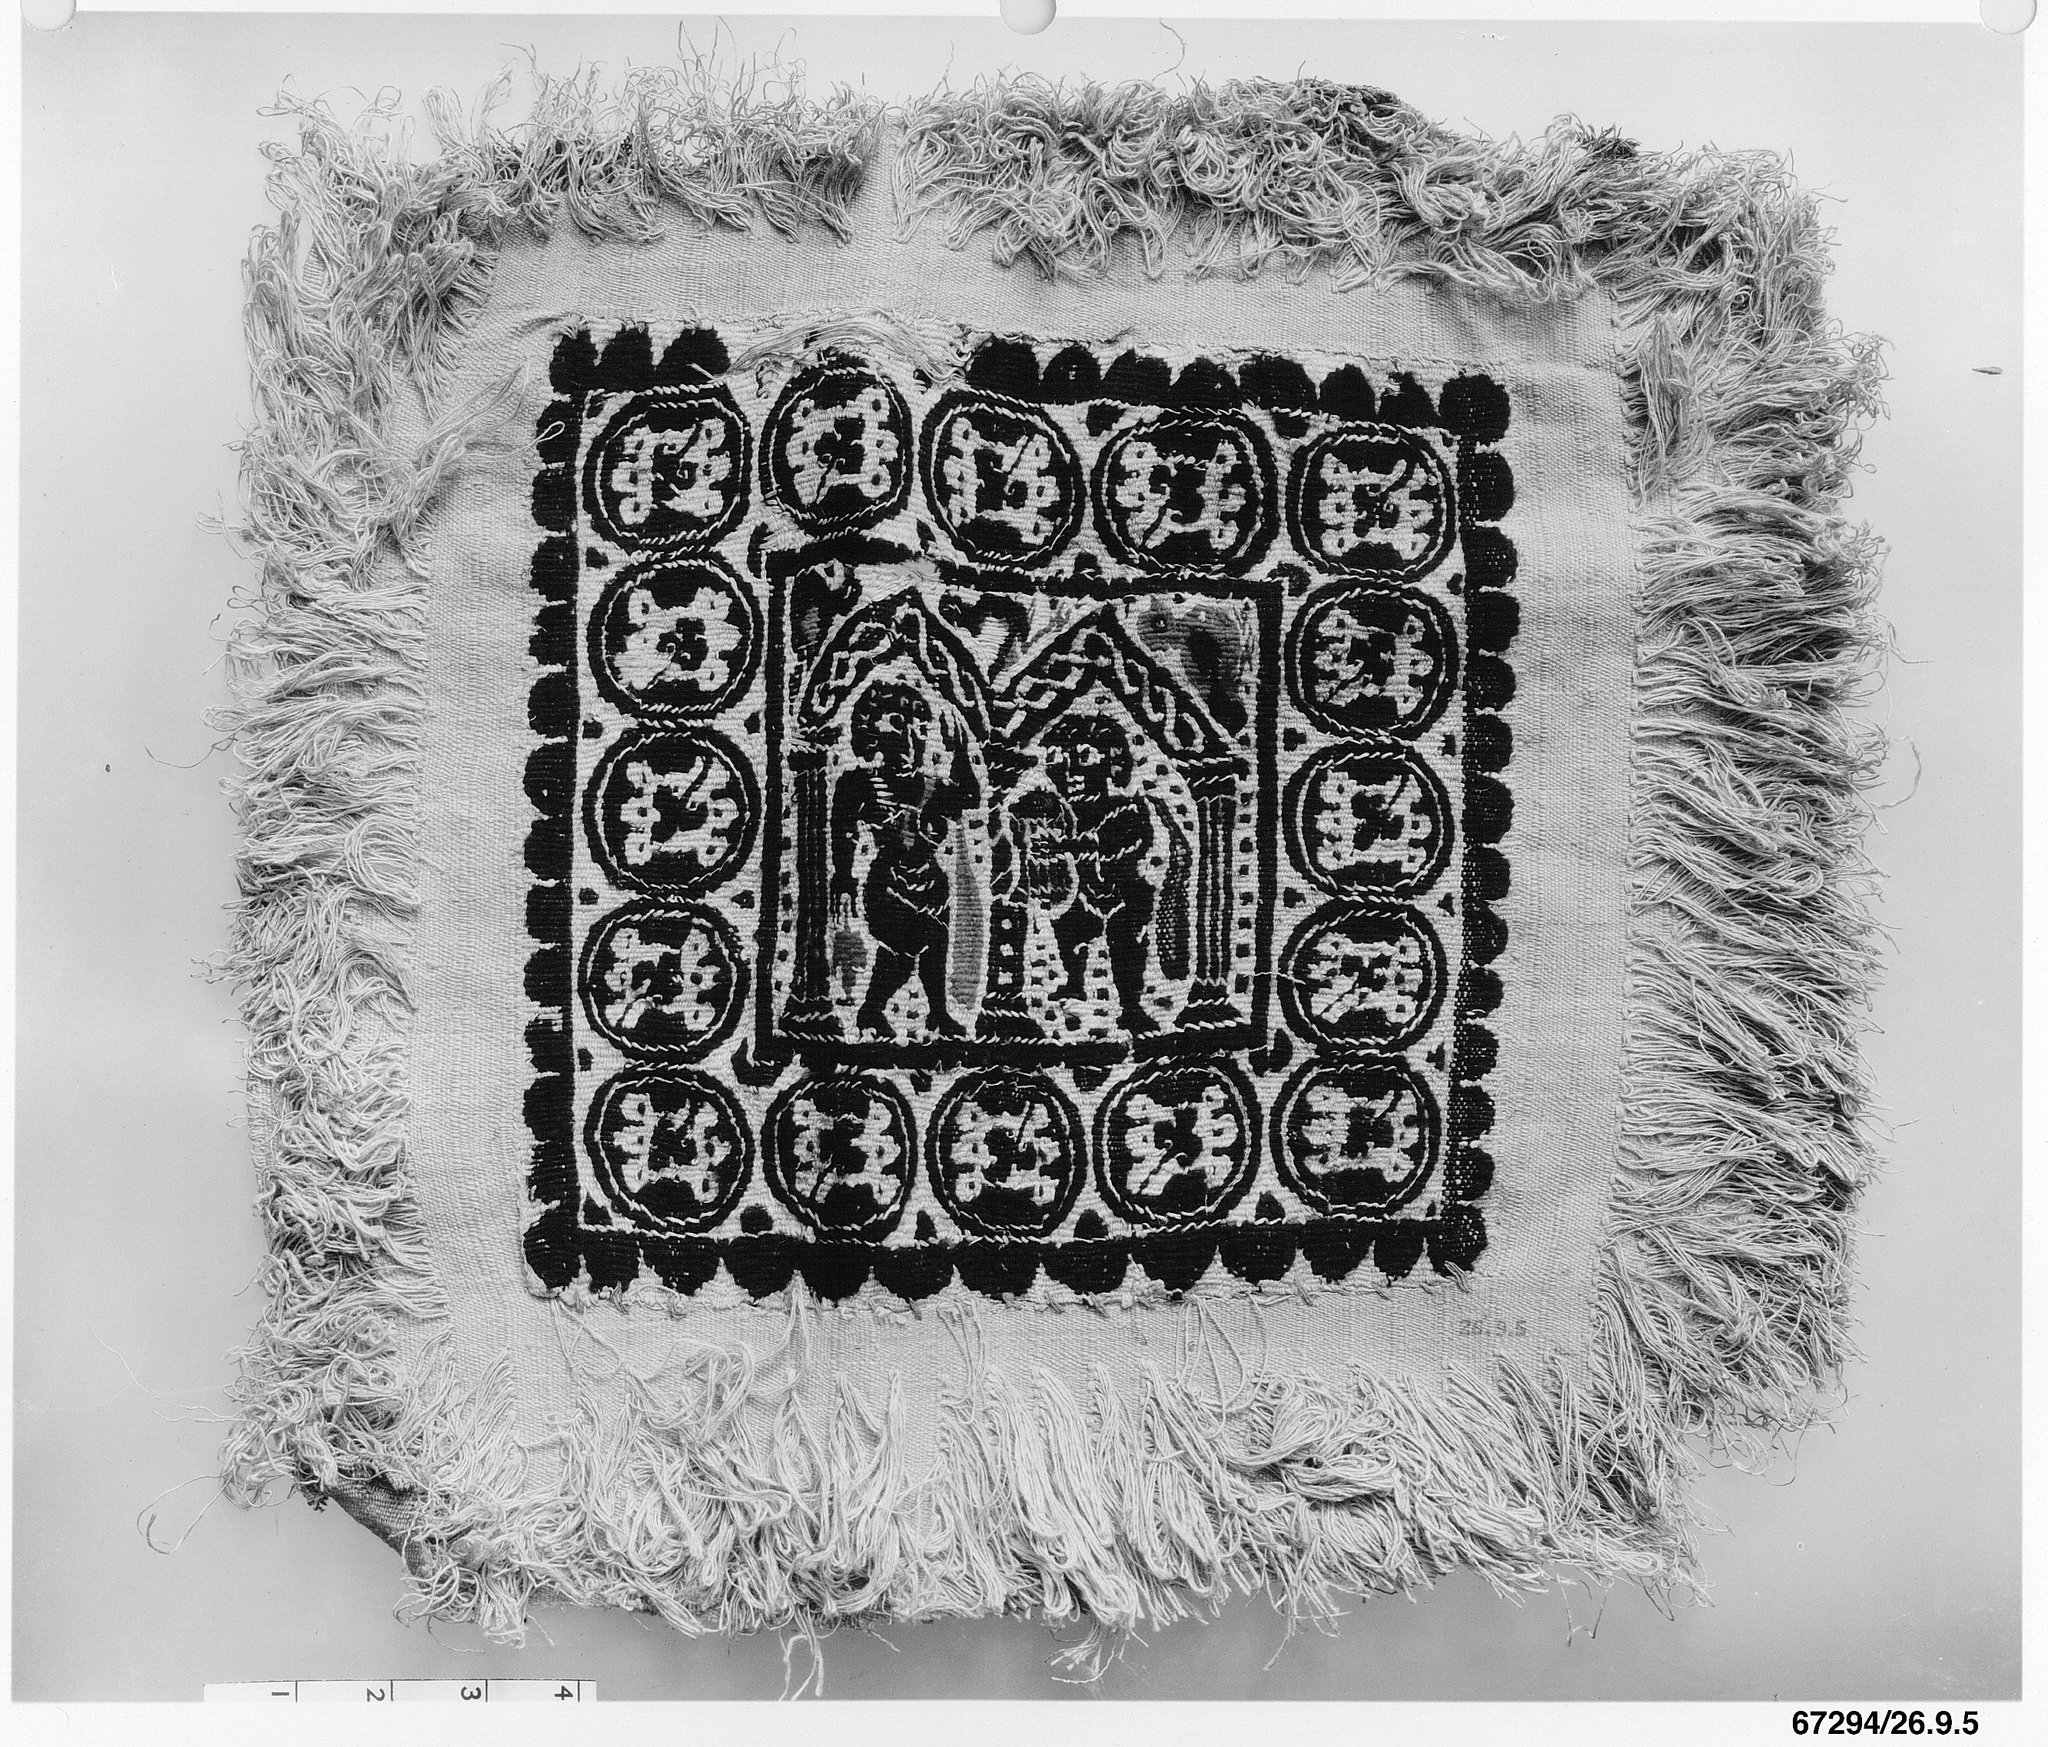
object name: square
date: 301-400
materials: linen, wool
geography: egypt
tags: human figures